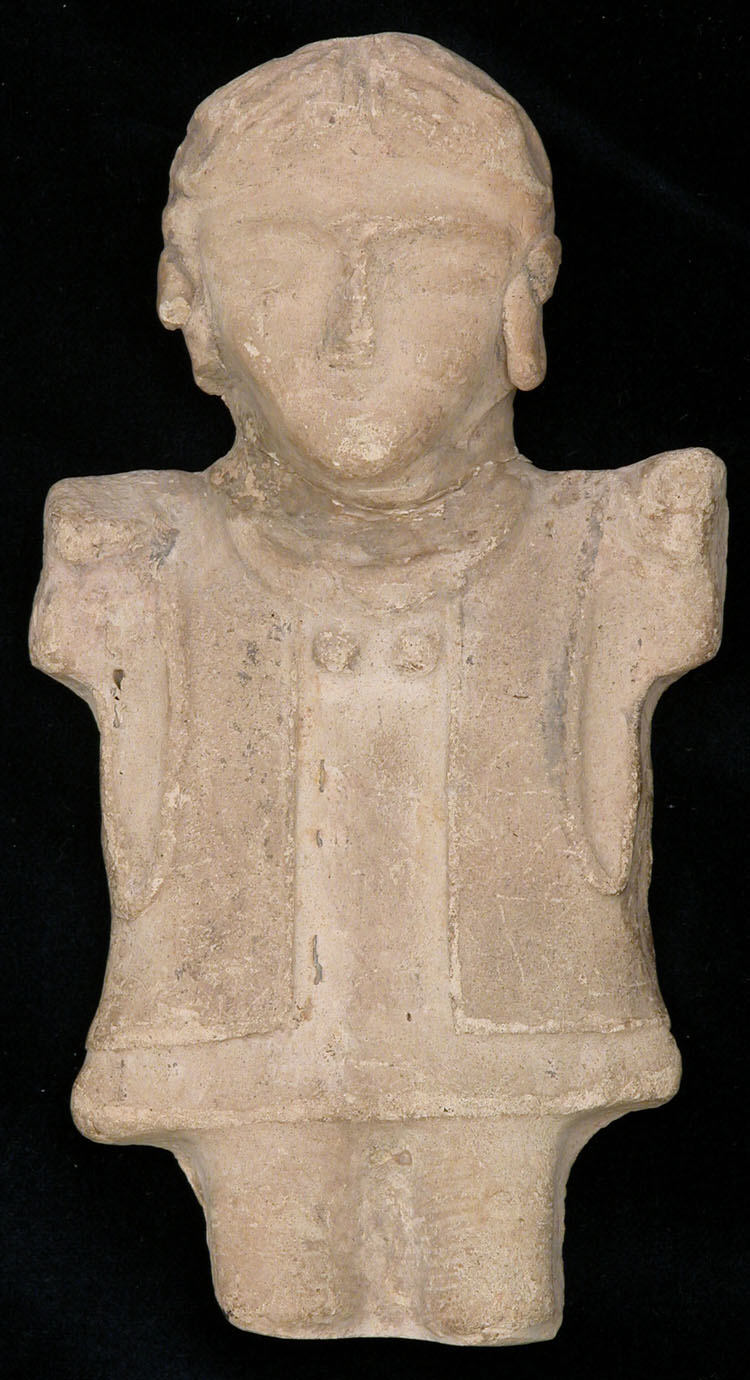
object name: figure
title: Figurine of a Female (?) Standing Personage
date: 1101-1300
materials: earthenware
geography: iran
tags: men